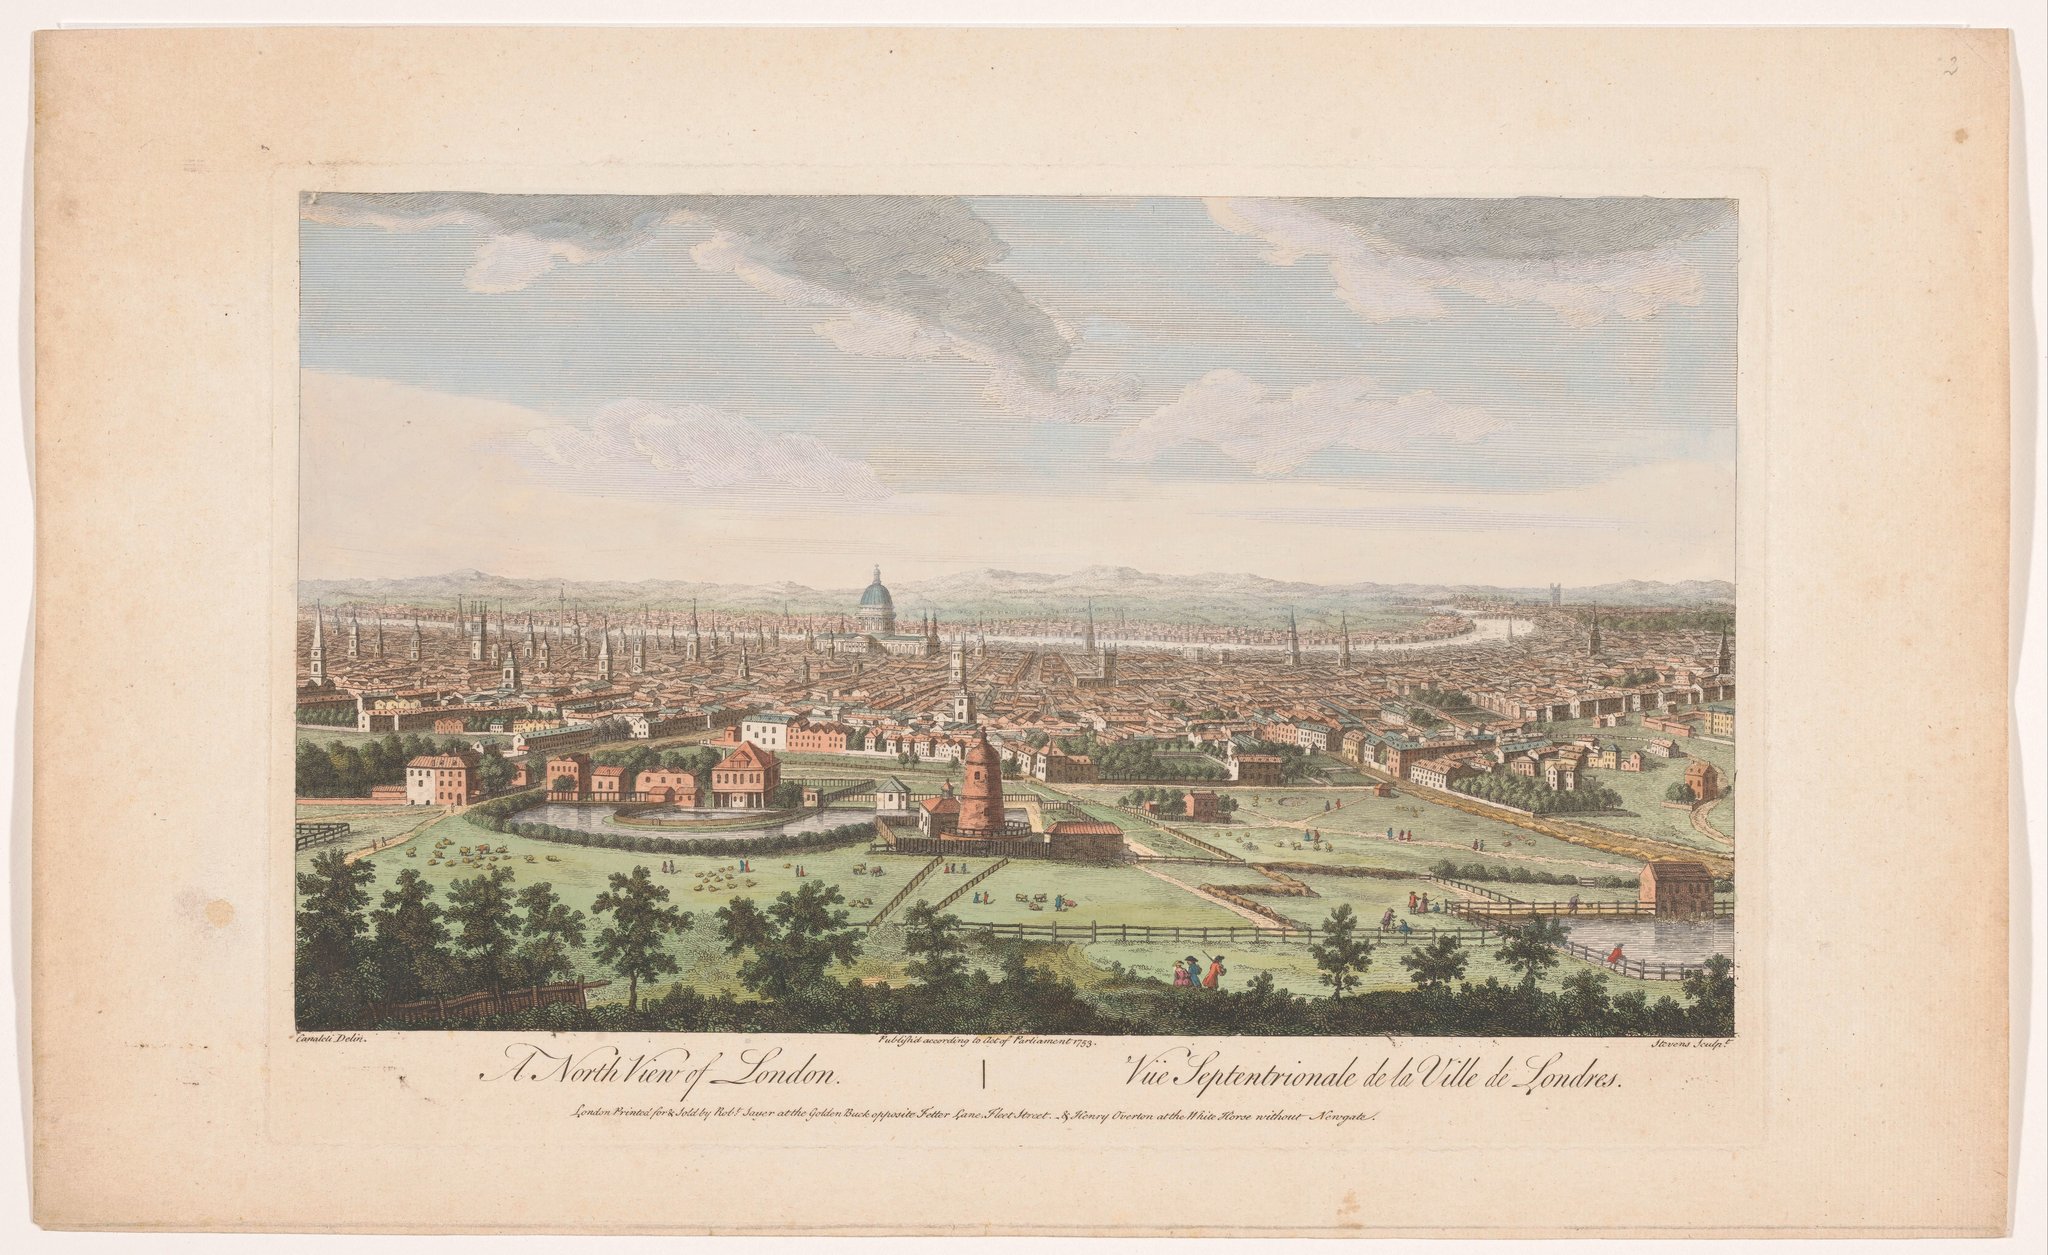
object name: print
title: Londen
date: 1753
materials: paper, watercolor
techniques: brush, etching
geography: london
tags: church (exterior), city-view in general; 'veduta' (+ city(-scape) with figures, staffage), london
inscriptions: watermark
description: De serie “Londen” bevat 52 prenten met de nummers 1-52, waarvan dit nummer 2 is.